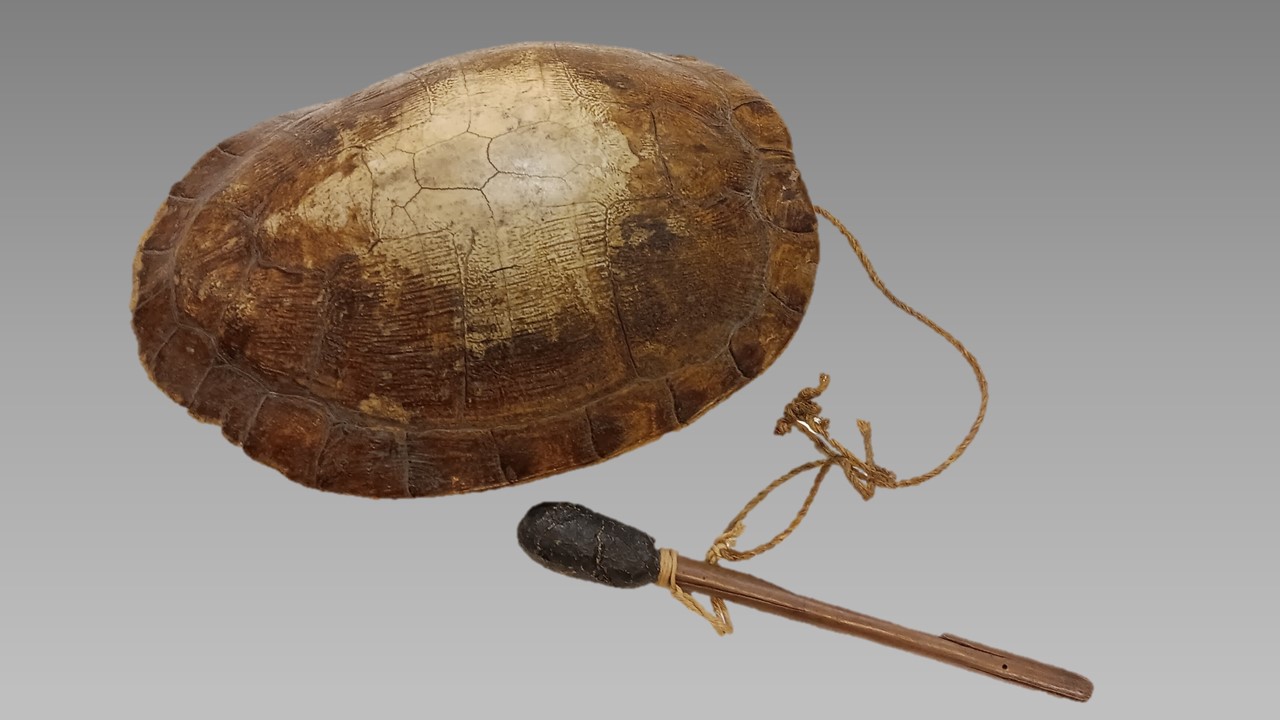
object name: coc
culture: guatemalan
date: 1801-1900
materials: shell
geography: guatemala